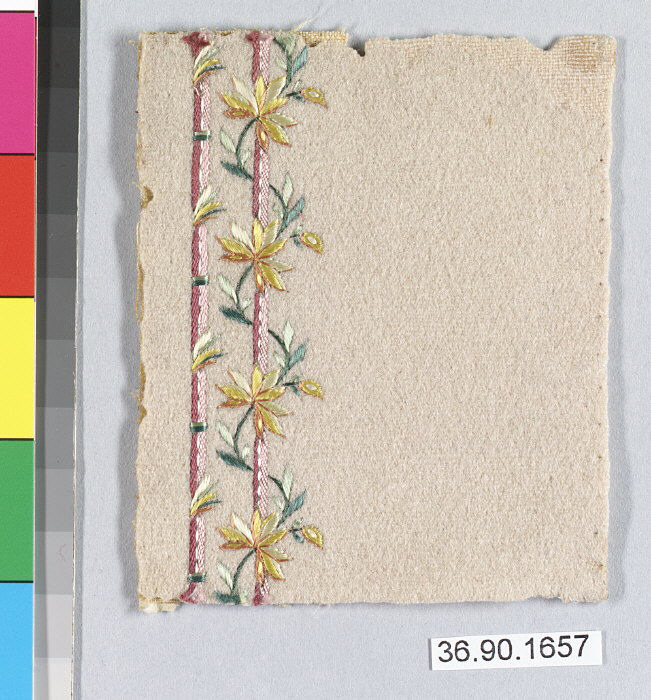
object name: sample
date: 1801-1833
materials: felt, silk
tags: flowers